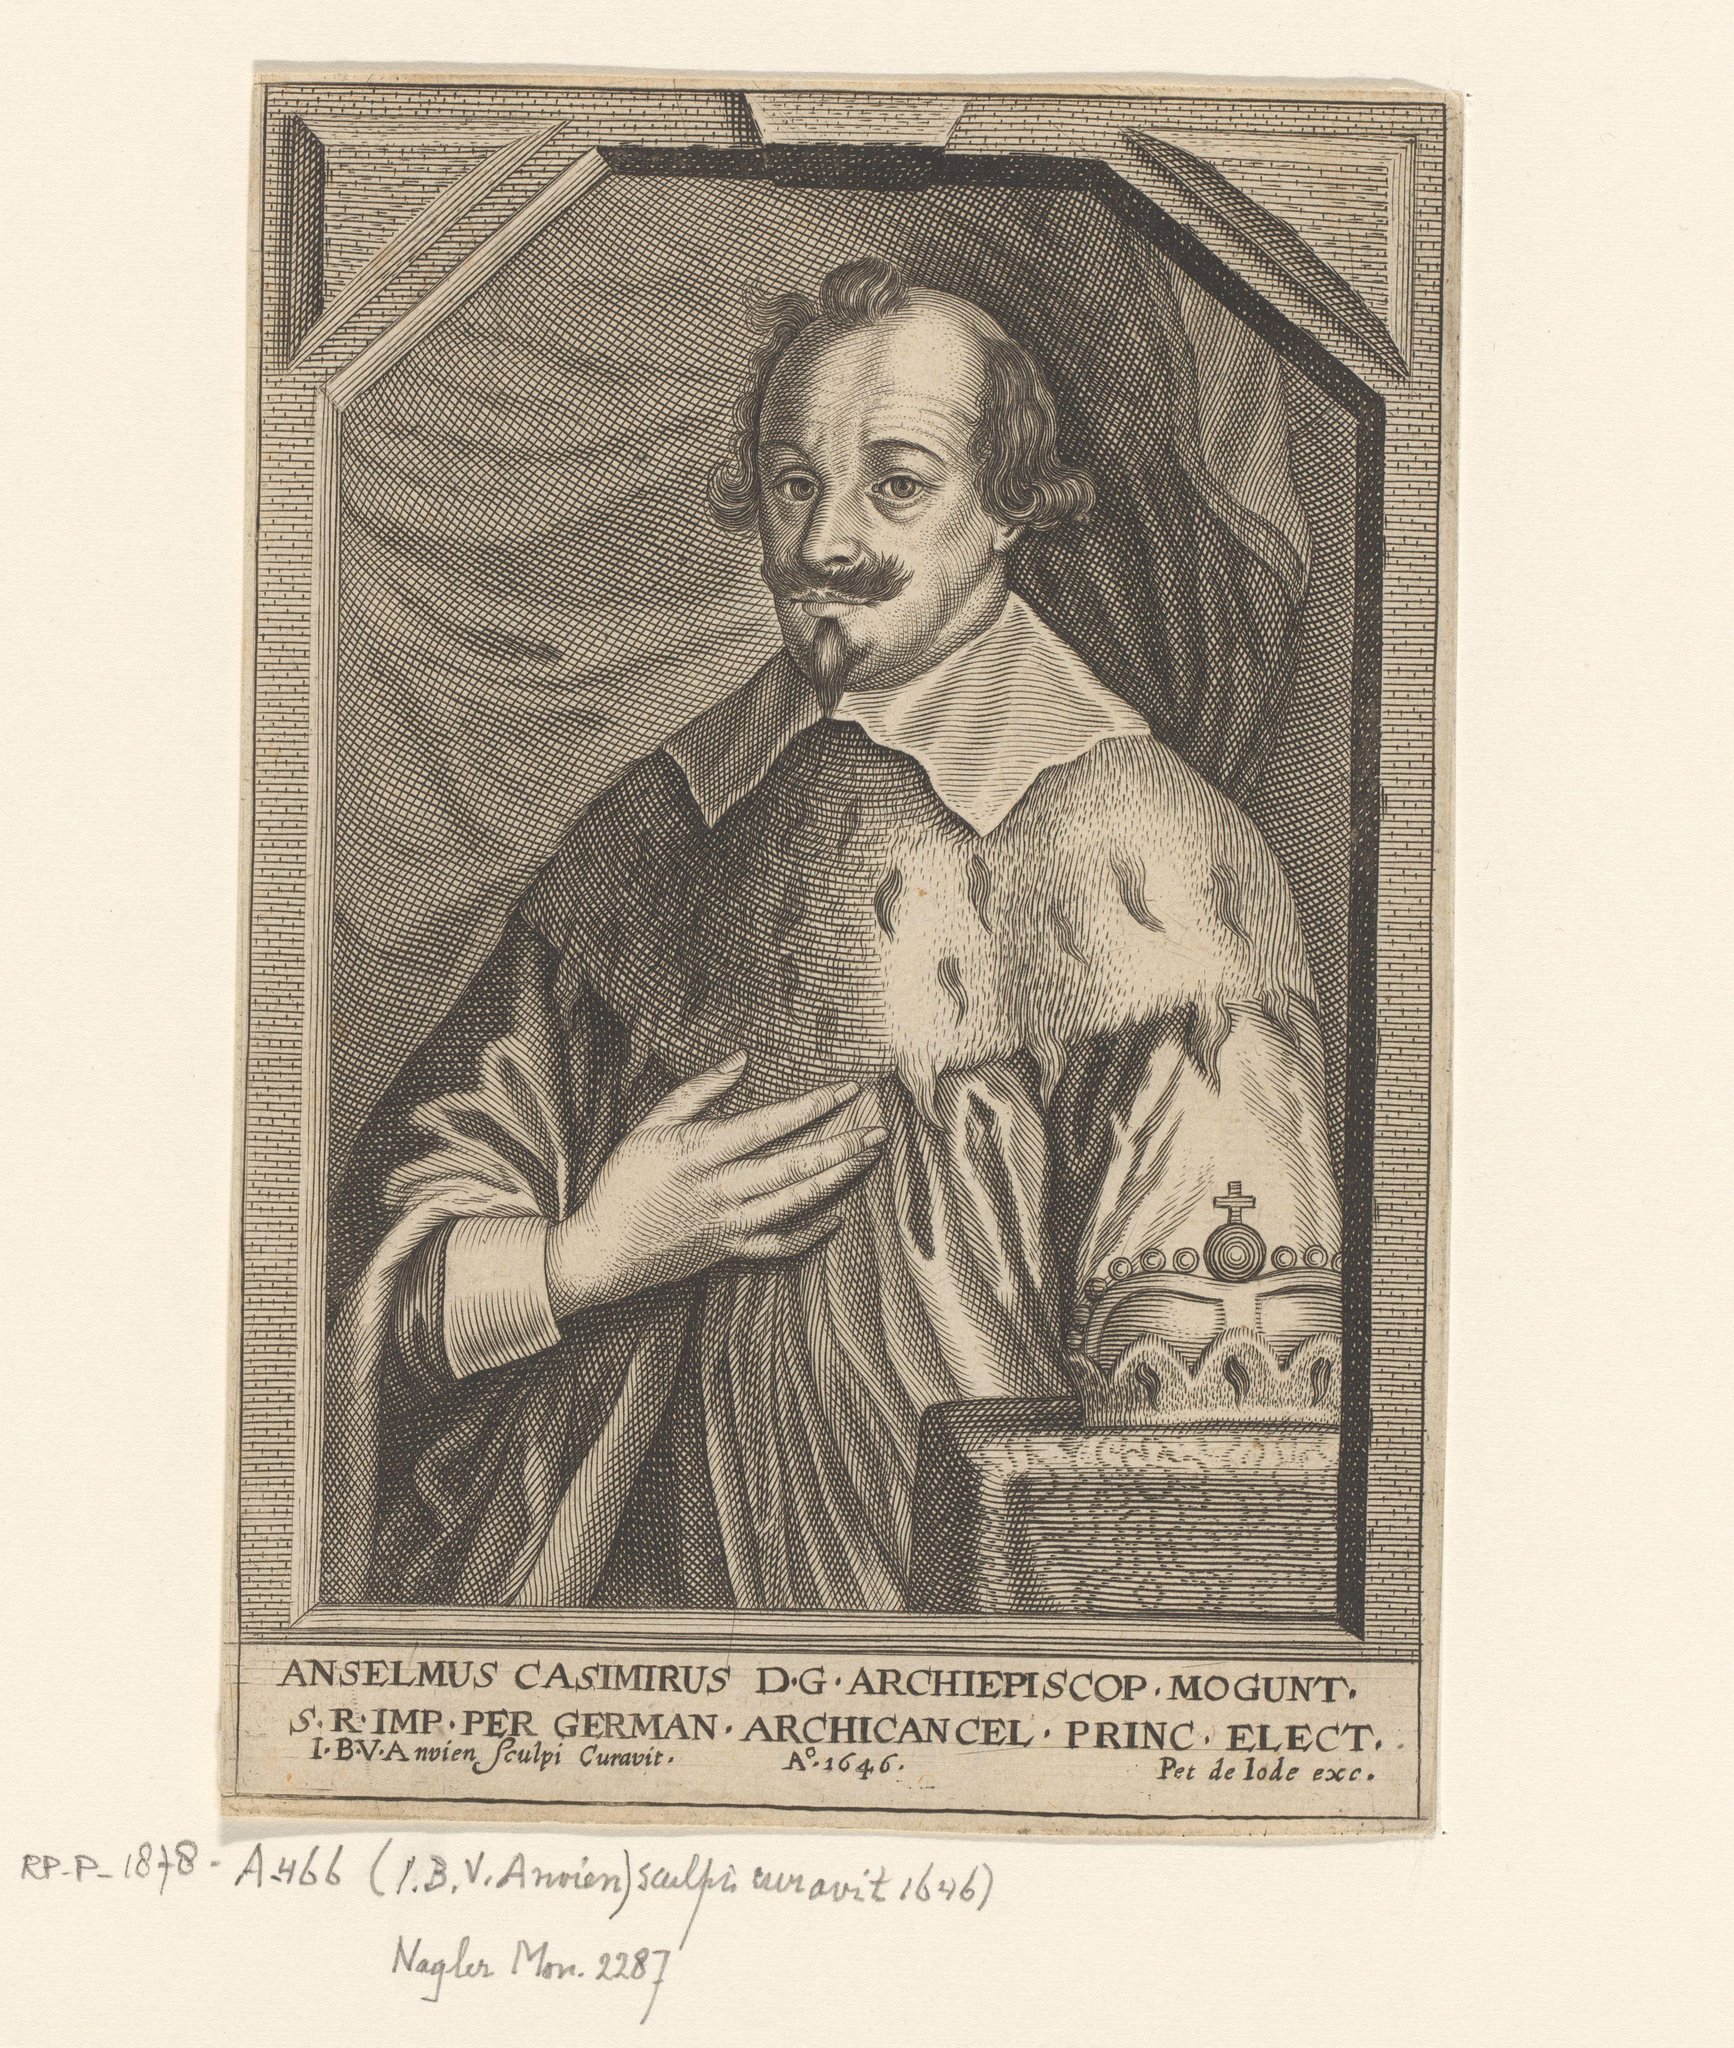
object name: print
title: Theatrum pontificum, imperatorum, regum, ducum, principum, etc.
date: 1646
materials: paper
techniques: engraving, etching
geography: antwerp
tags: crown (symbol of sovereignty), archbishop, bishop, etc. (roman catholic), historical persons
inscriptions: collector's mark: Lugt 2228